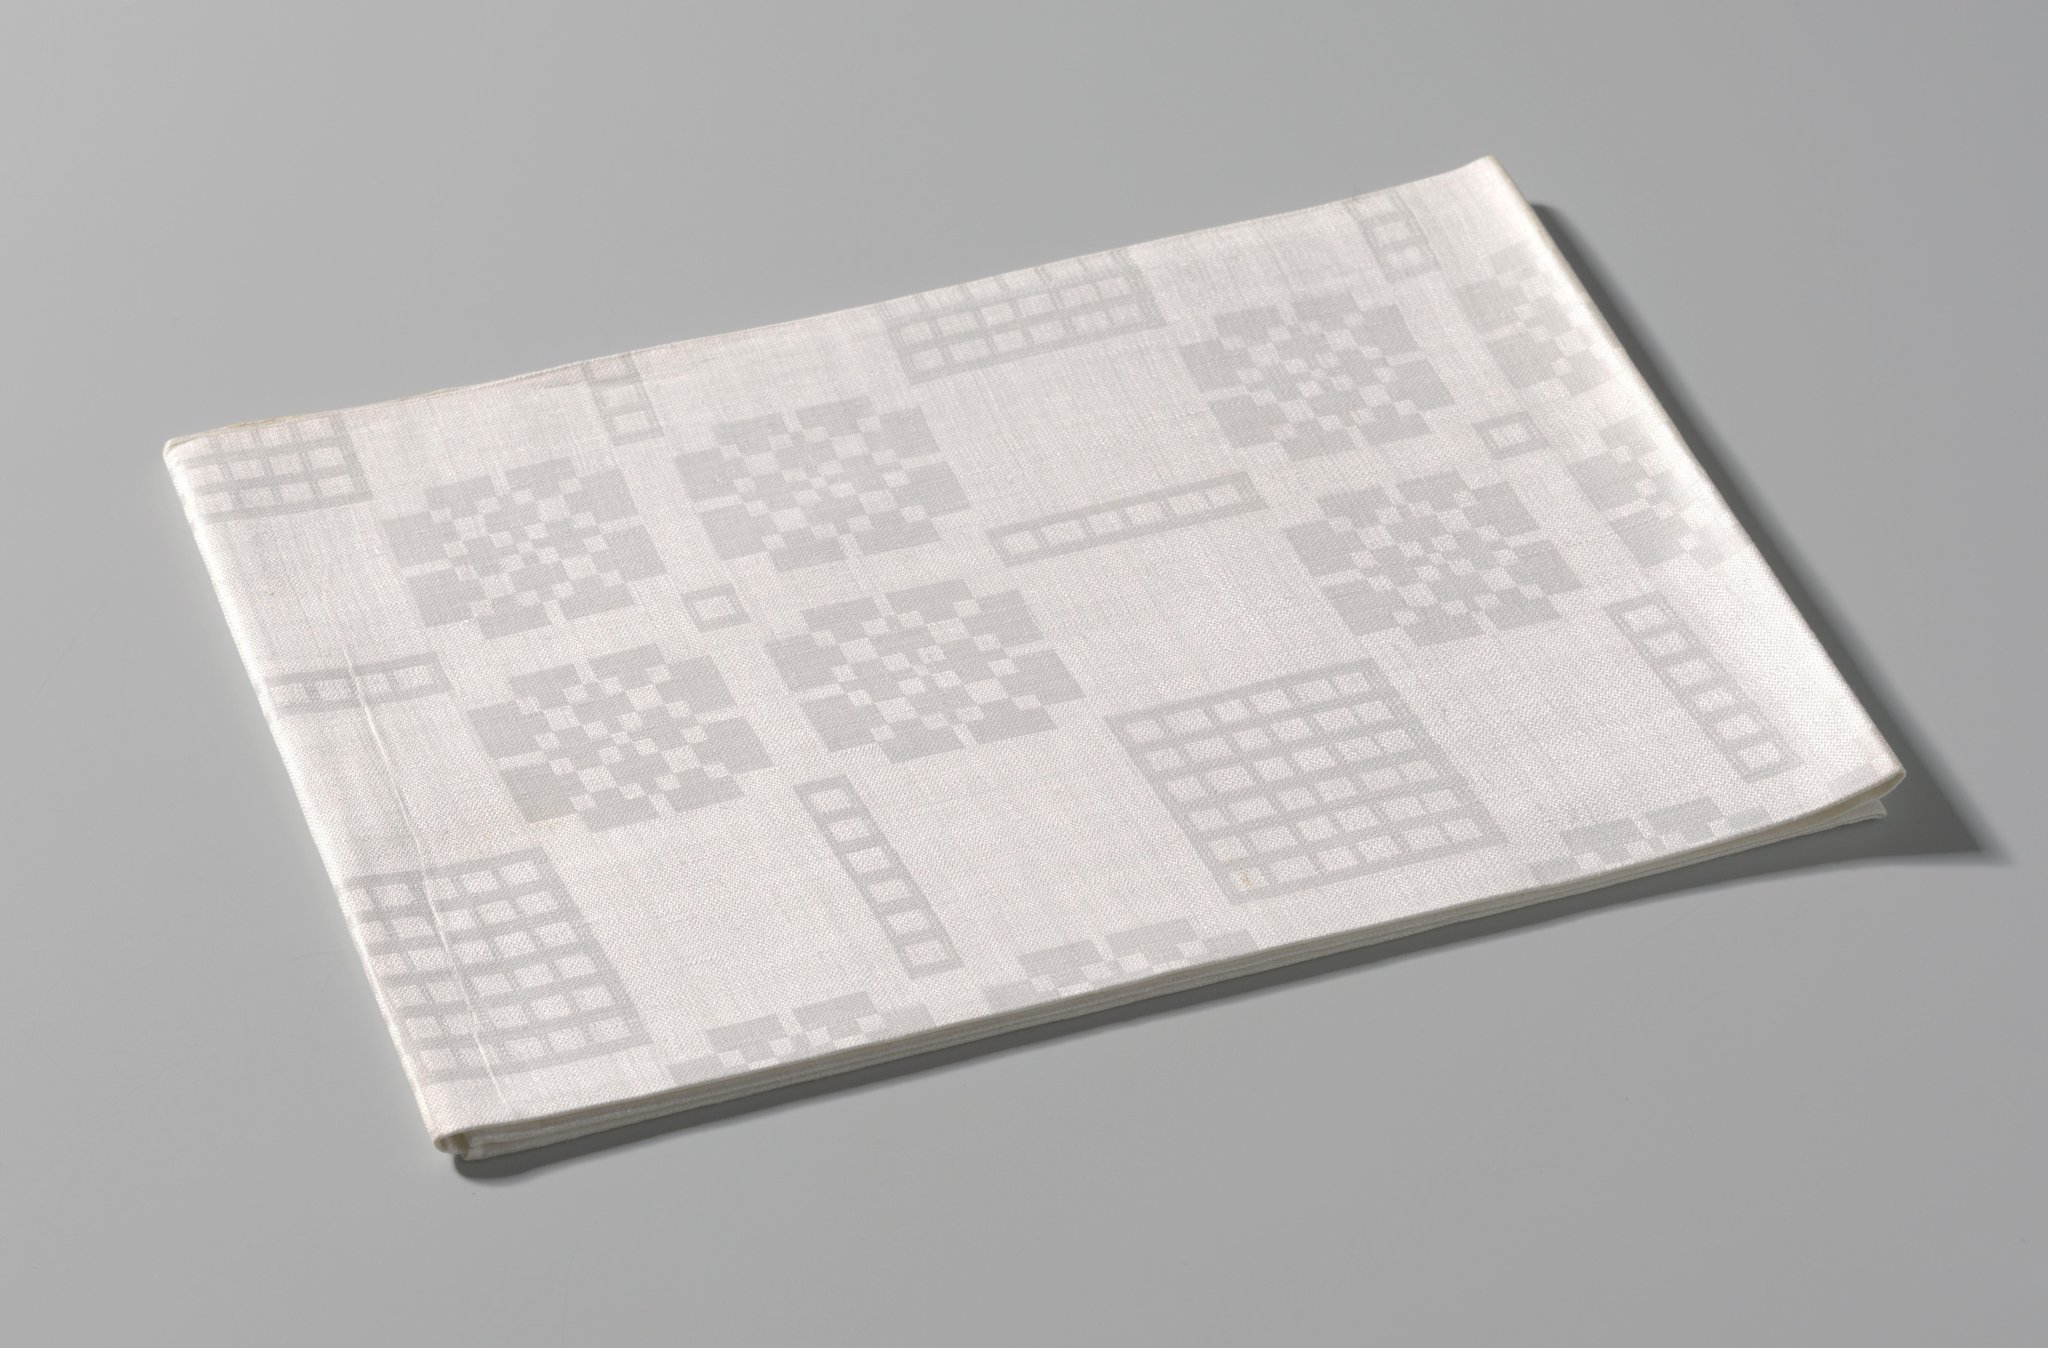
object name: napkin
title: Servet van linnen met pellenpatroon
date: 1400-1950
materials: linen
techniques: peeled fabric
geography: northern netherlands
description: wit linnen servet met pellen patroon, merk IS en 47